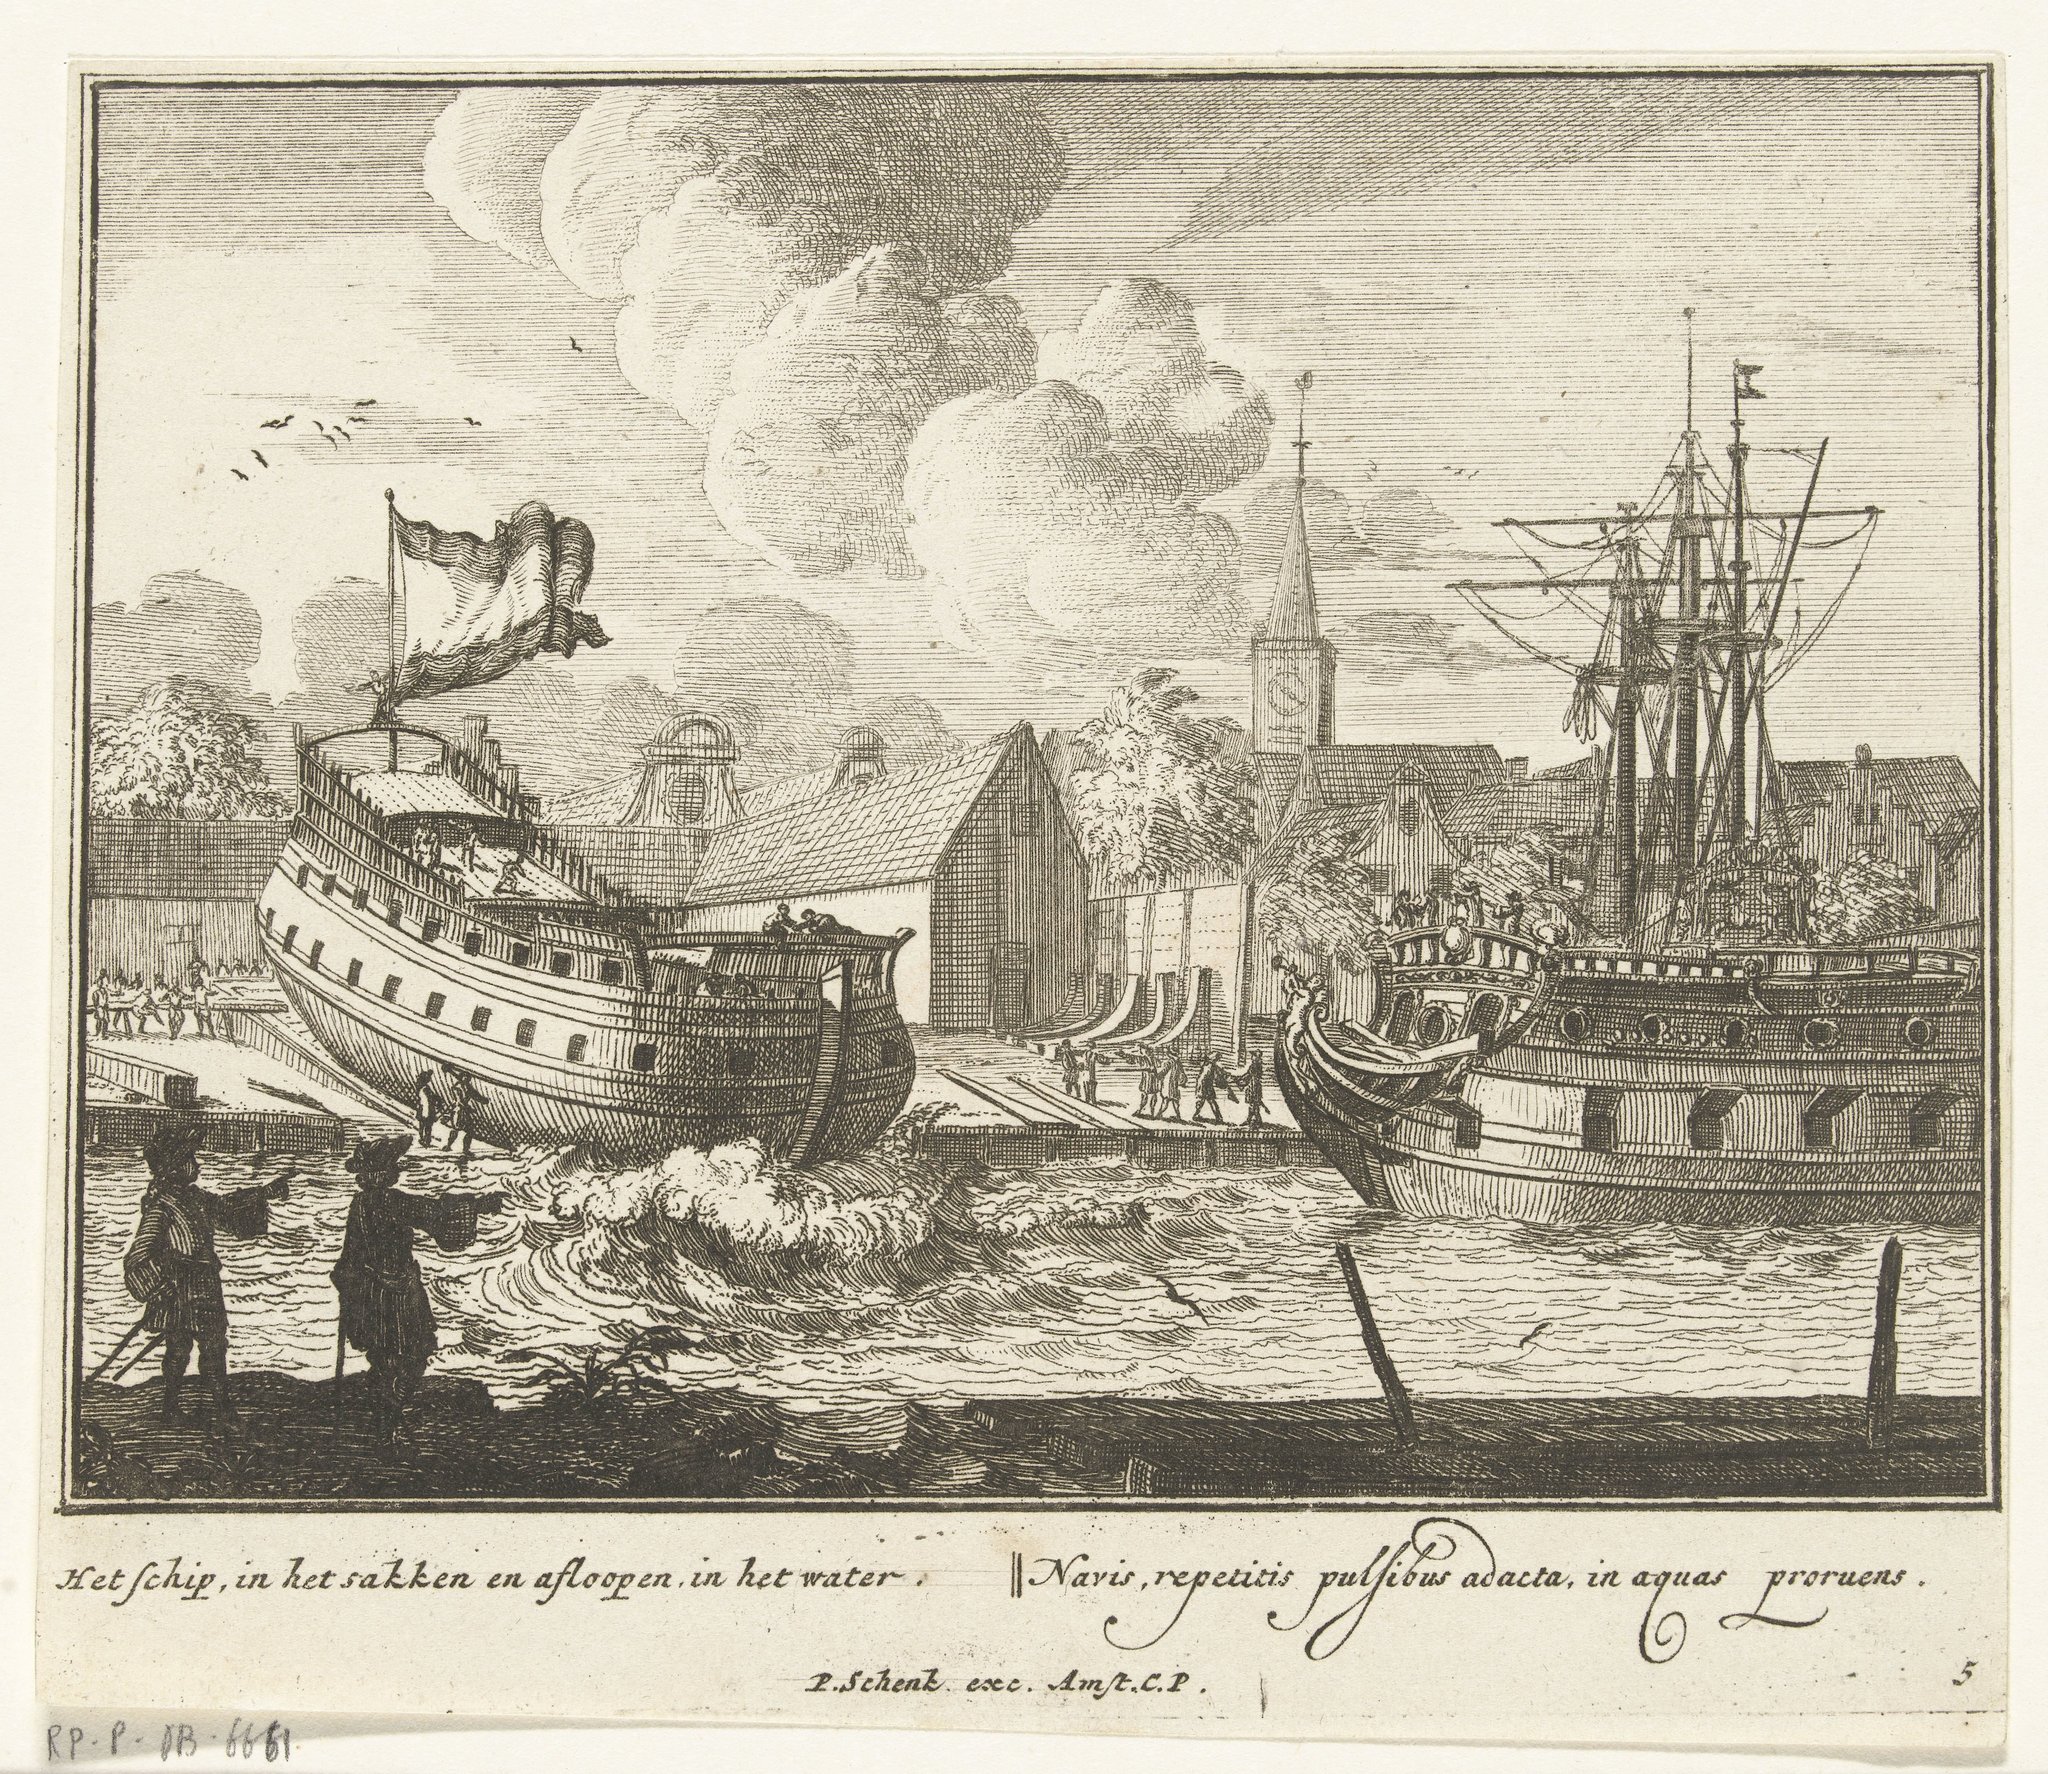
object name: print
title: De bouw en de lotgevallen van een schip in 16 platen, ca. 1700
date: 1690-1710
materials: paper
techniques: etching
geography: amsterdam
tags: launching a ship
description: Het te water laten van het schip op de scheepswerf. No. 5 uit serie van 16 prenten waarop de bouw en lotgevallen van een schip zijn afgebeeld. Met onderschriften in het Nederlands en Latijn.